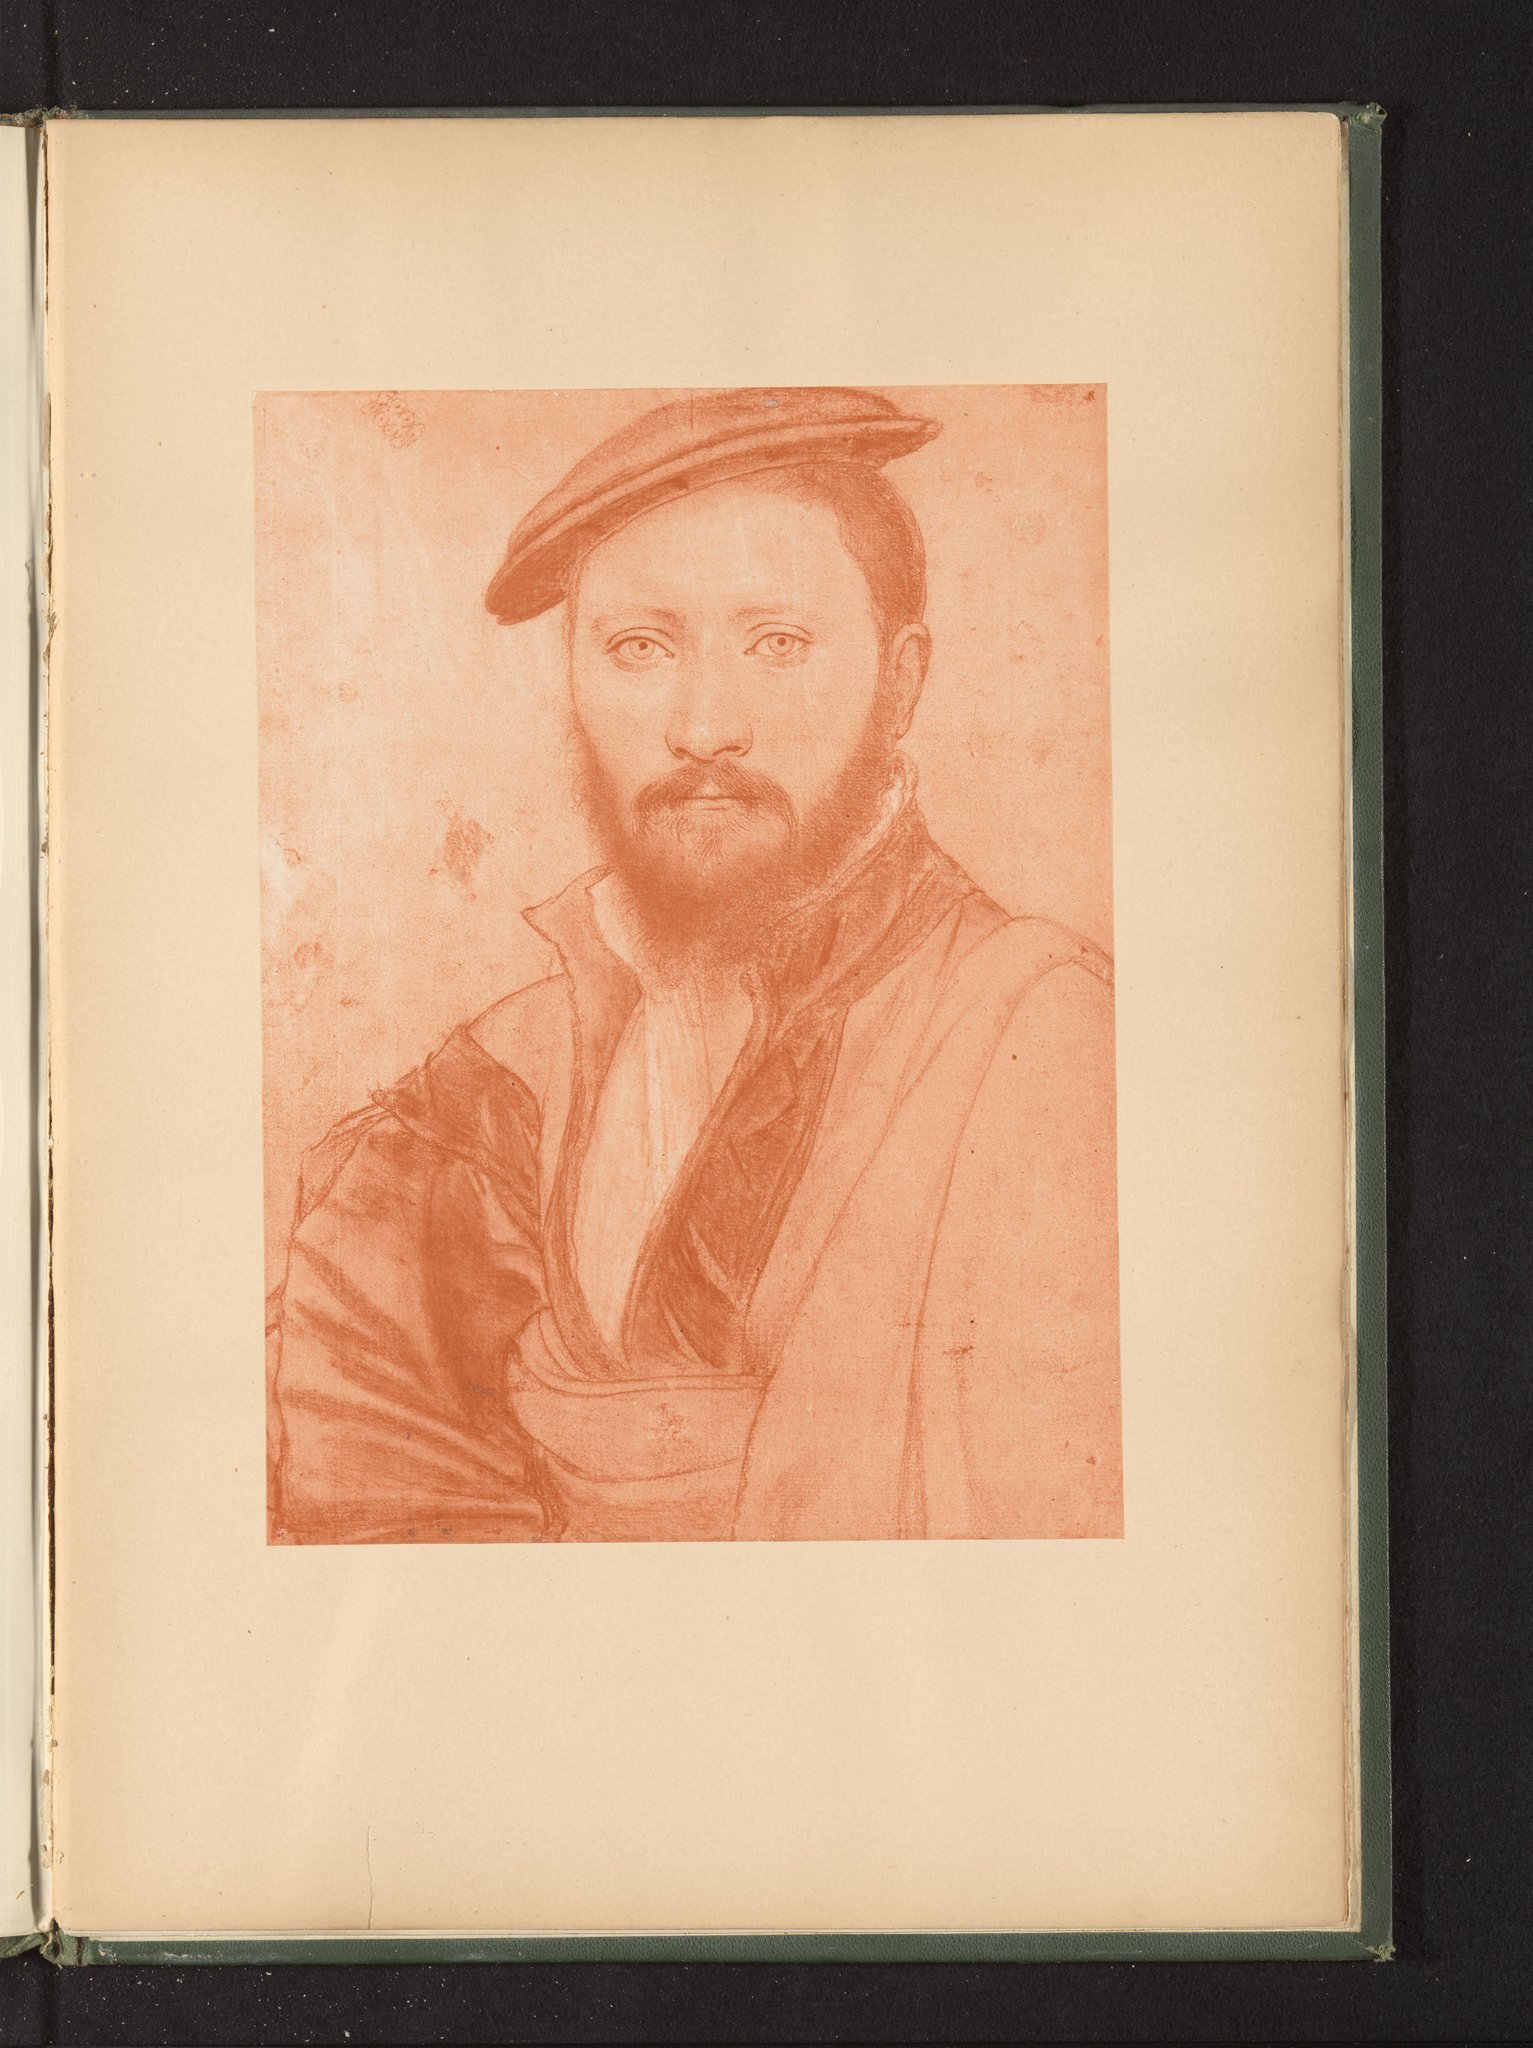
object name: reproduction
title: Fotoreproductie van een portret van een onbekende man door Hans Holbein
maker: Anonymous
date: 1872-1877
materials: paper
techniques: carbon print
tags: drawing, sketch, historical persons